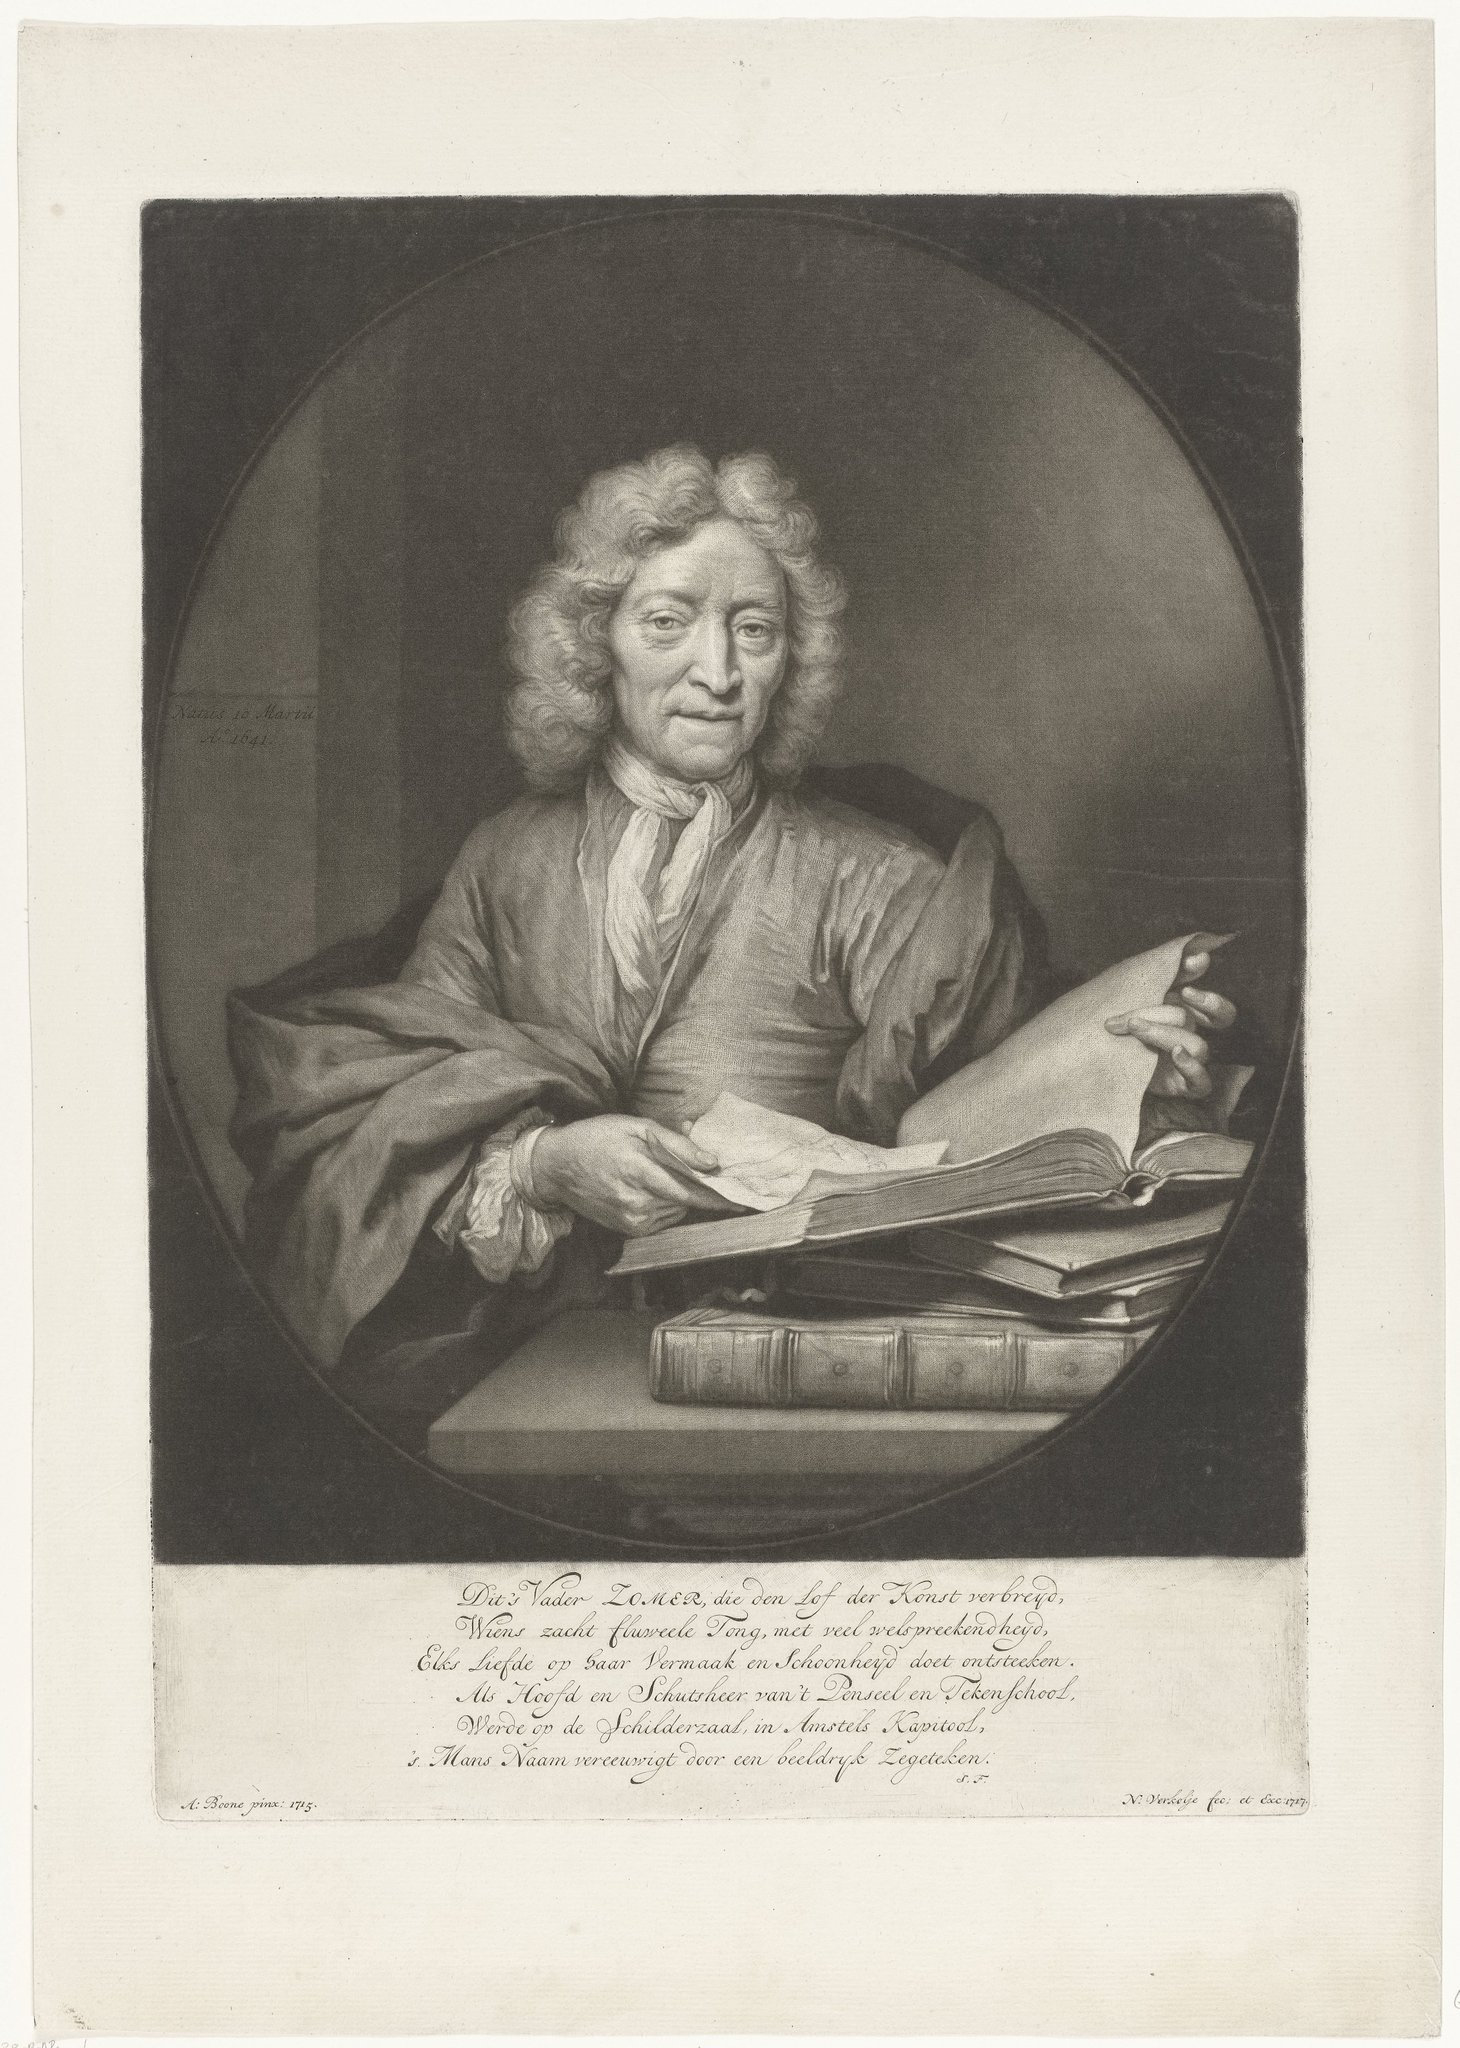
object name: print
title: Portret van Jan Pietersz. Zomer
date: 1717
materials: paper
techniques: engraving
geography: amsterdam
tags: amsterdam, draughtsman, jan pietersz. zomer, print, e.g.: engraving, etching, lithograph, art dealer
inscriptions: collector's mark: Lugt 240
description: De kunsthandelaar Jan Pietersz. Zomer, zit aan een tafel en toont een afbeelding in een opengeslagen album. In de marge een lofdicht op zijn welbespraaktheid en kwaliteiten als kunsthandelaar.